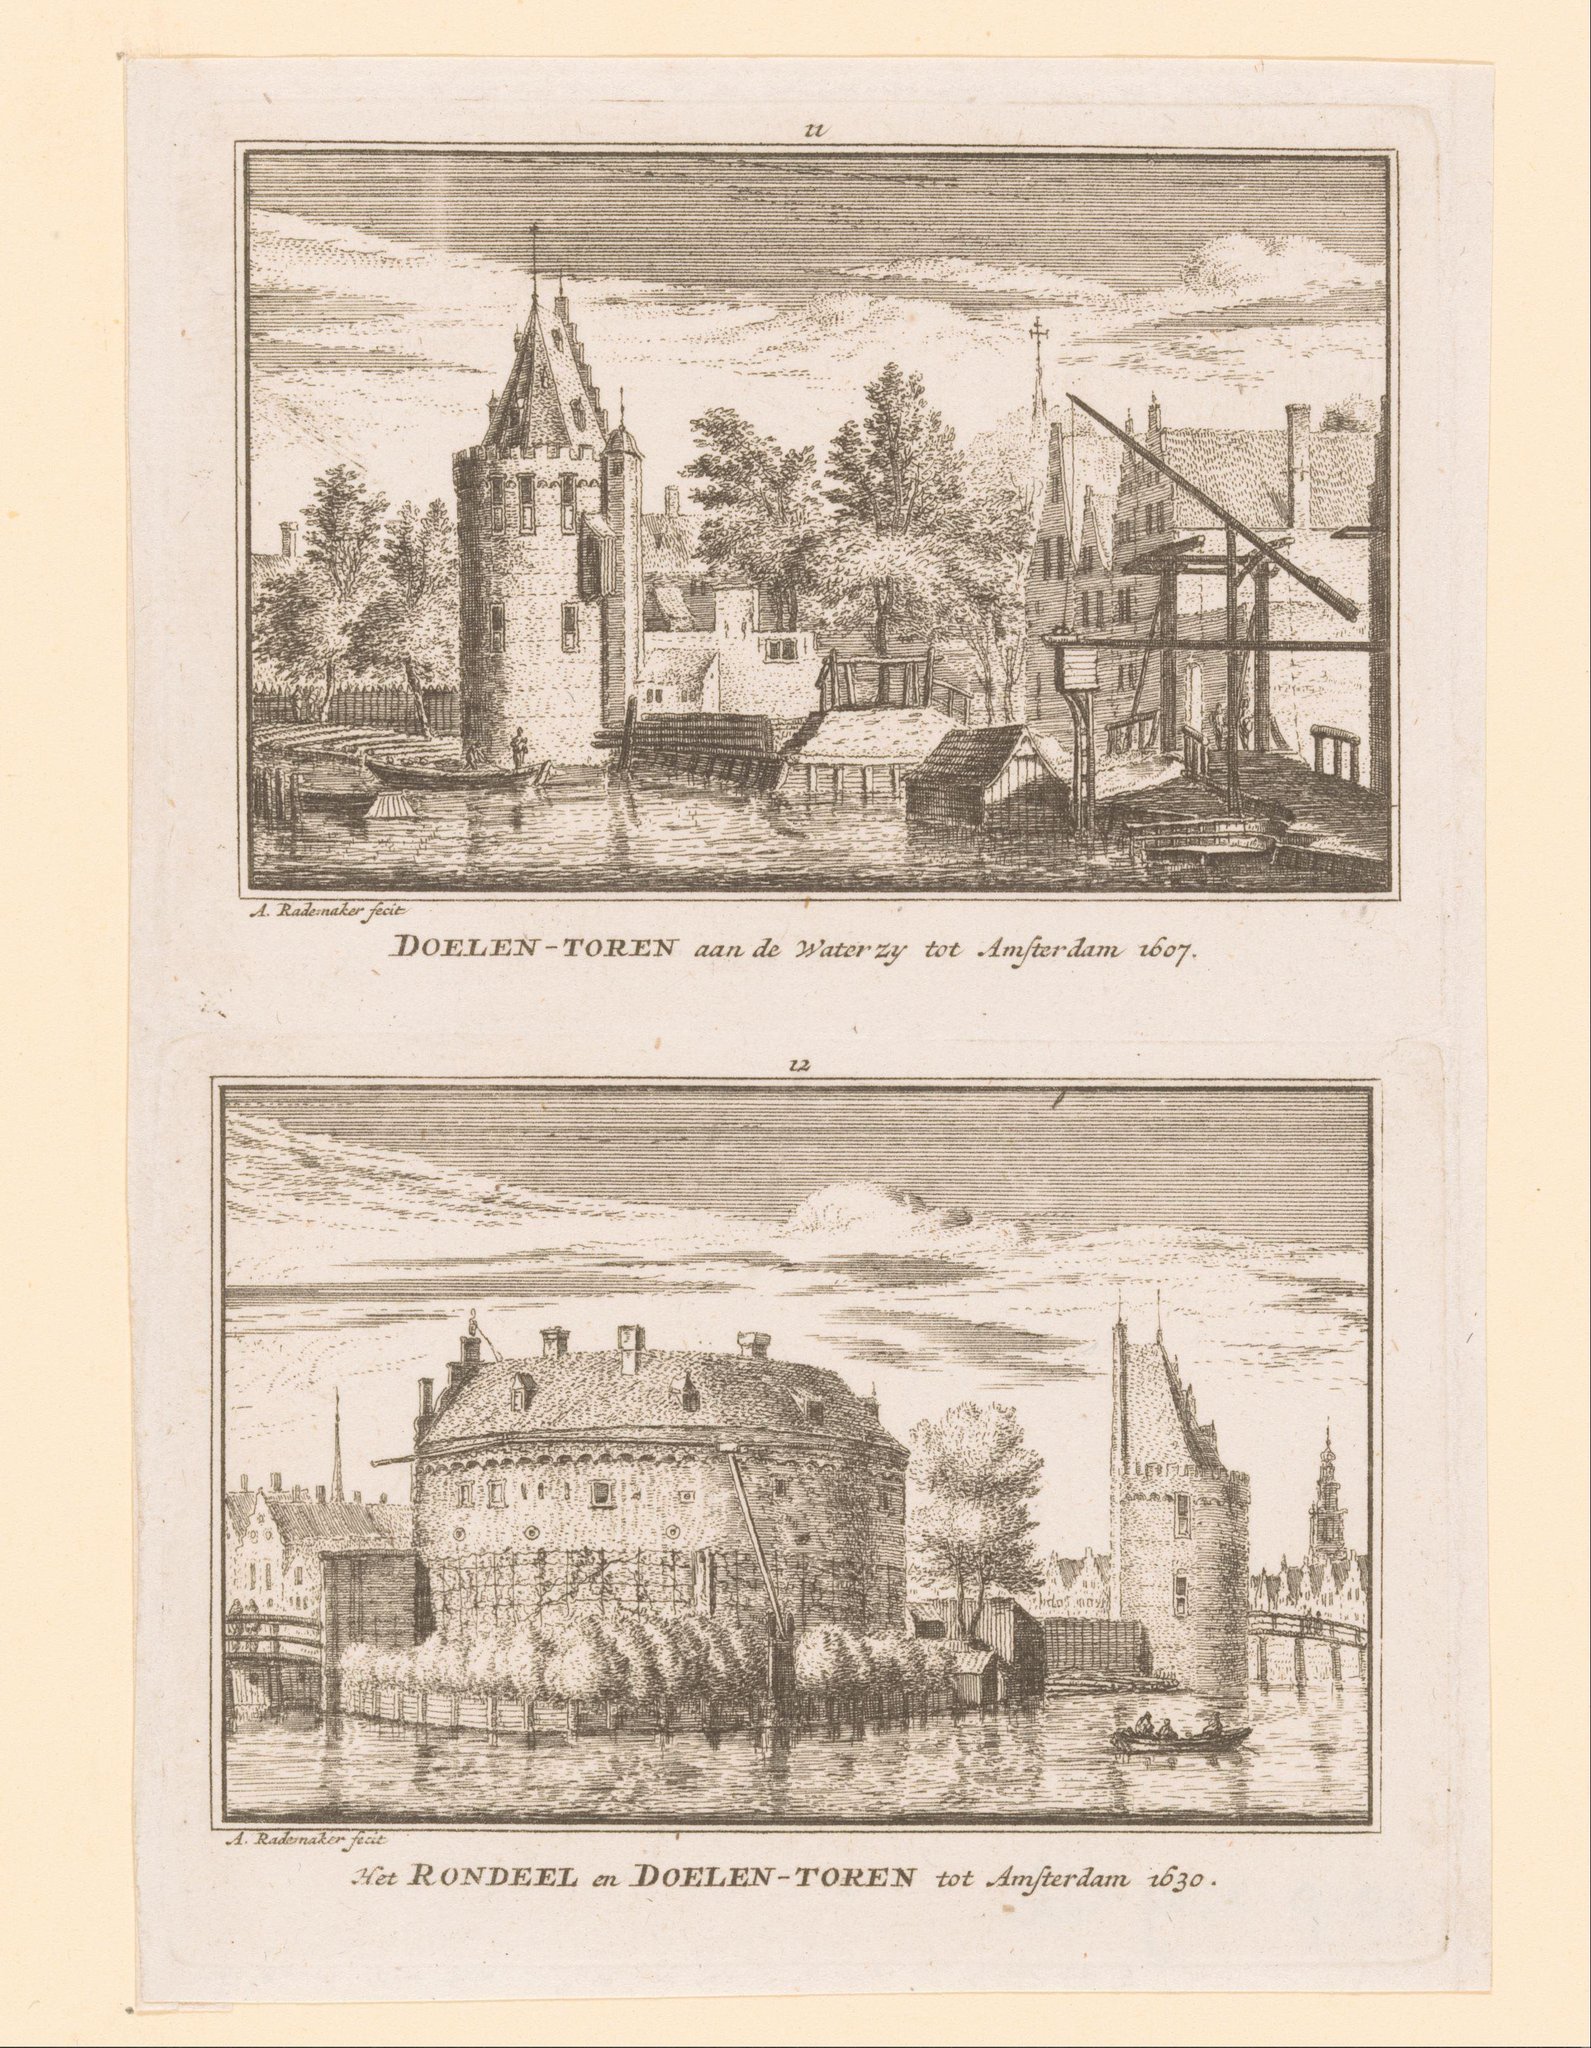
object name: print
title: Twee gezichten op de Kloveniersdoelen in Amsterdam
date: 1725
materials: paper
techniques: etching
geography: amsterdam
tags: urban housing, rowing-boat, canoe, etc., bridge in city across river, canal, etc., tower (of house or building), parts of church exterior and annexes: tower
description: Prent gebruikt in: Rademaker, Abraham. Kabinet van Nederlandsche outheden en gezichten: vervat in 300 konstplaaten (…). 2 dln. Amsterdam: Willem Barents, 1725, plaat 11. Na 1725 is deze prent nog in verschillende heruitgaven verschenen, in 1727-1733, 1770-1771 en 1792-1803. Uit welke uitgave het huidige exemplaar precies komt is niet na te gaan.